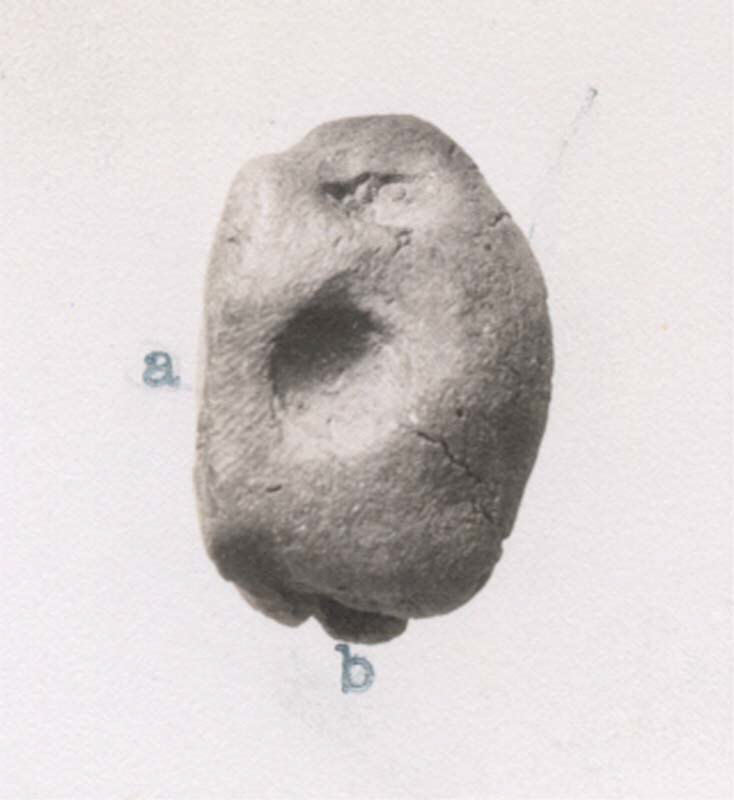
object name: sealing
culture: sasanian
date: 601-700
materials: clay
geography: iran